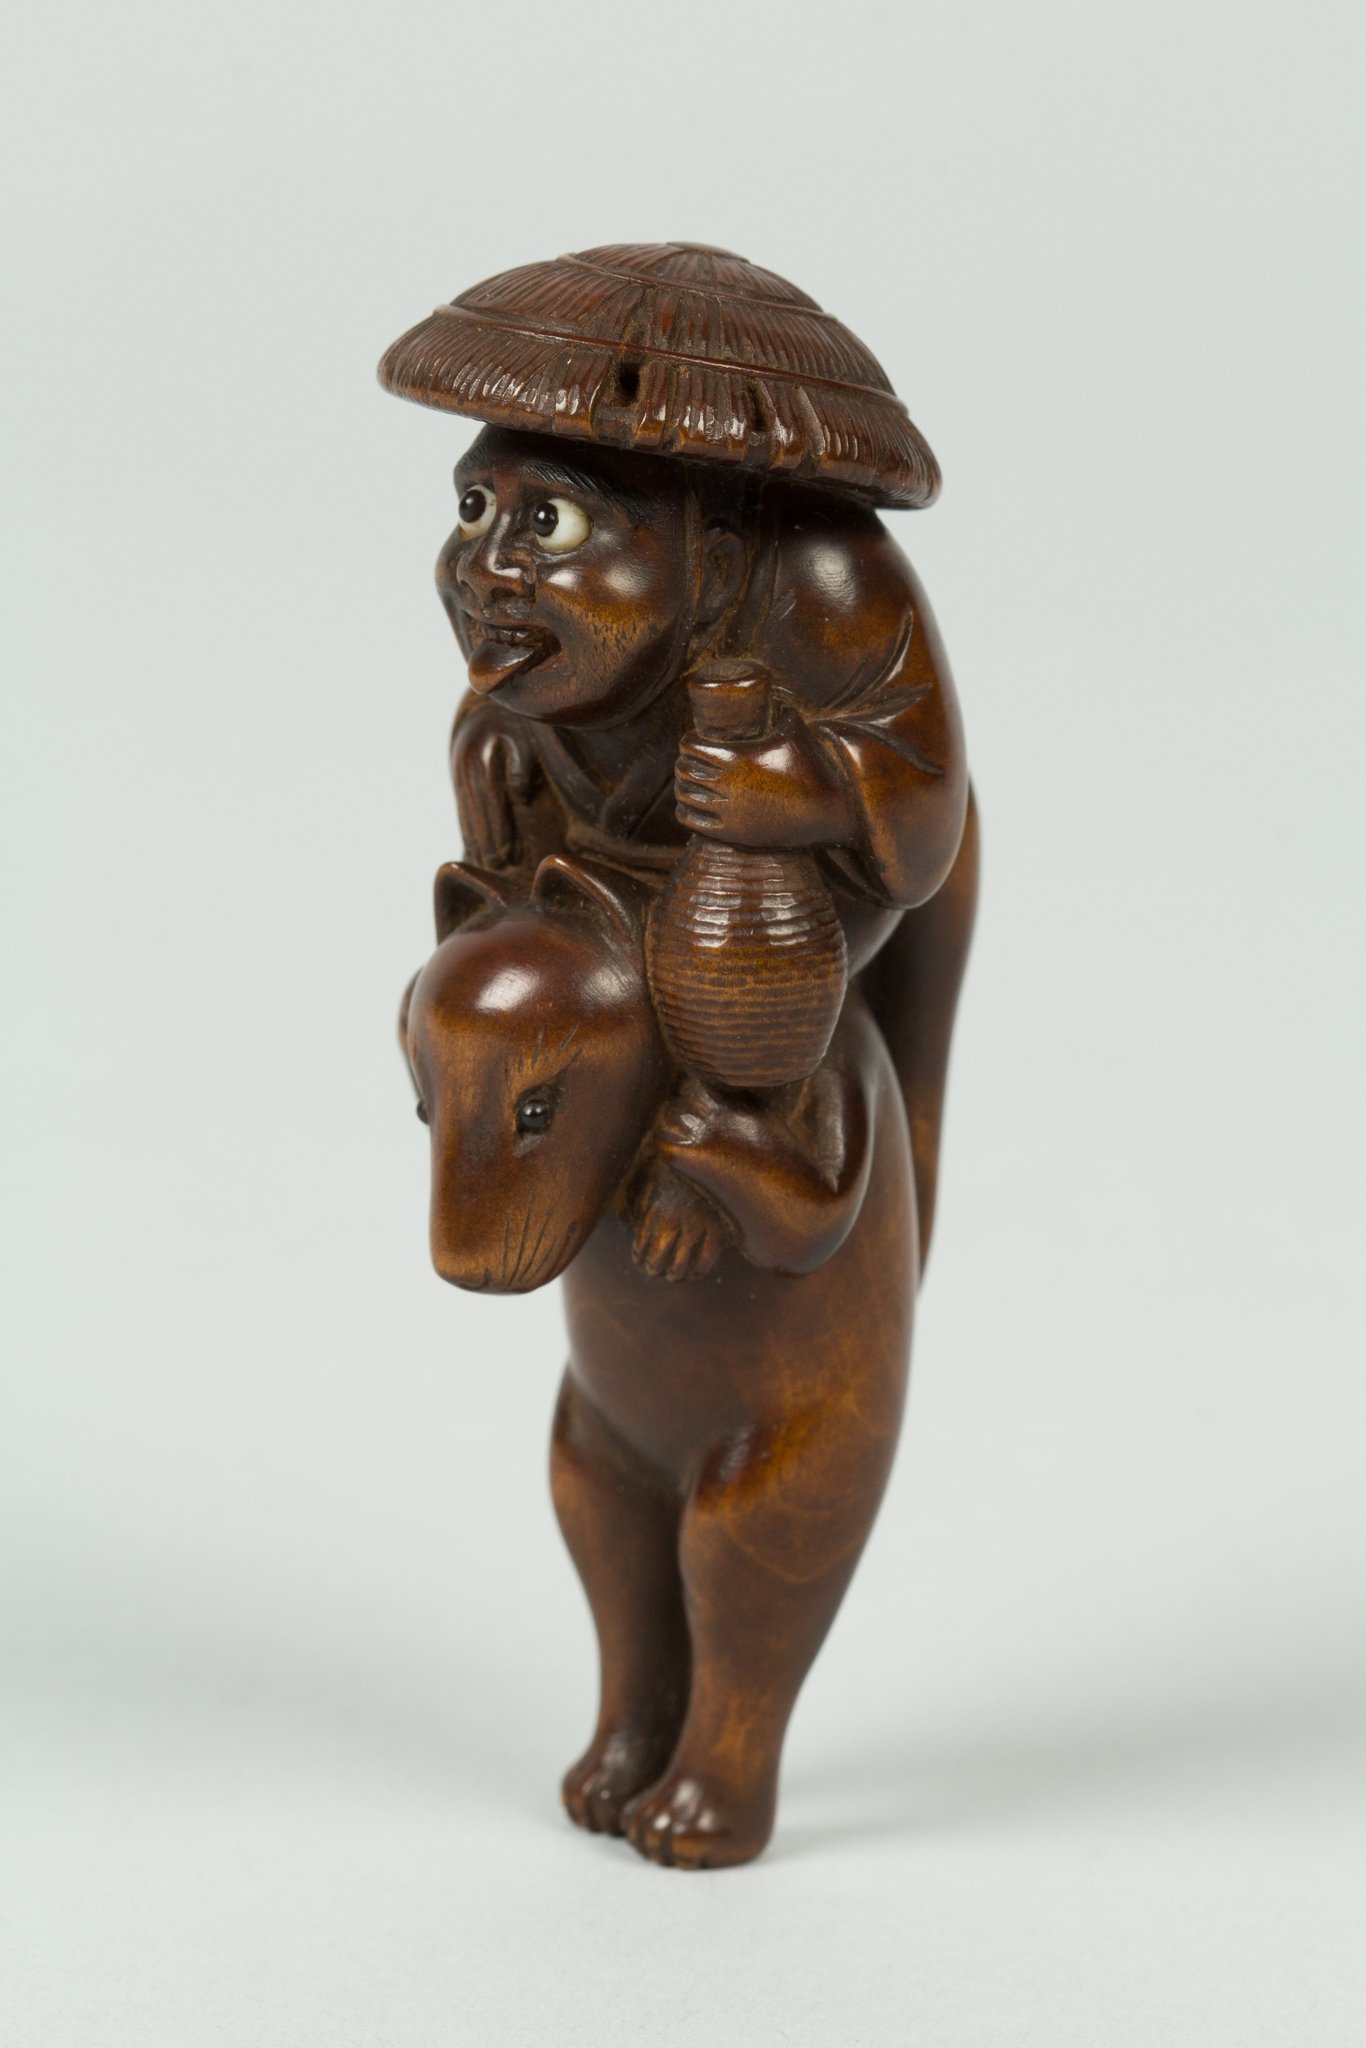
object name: netsuke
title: Netsuke of Boy Sitting on the Shoulders of an Animal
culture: japanese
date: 1701-1800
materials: wood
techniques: inlay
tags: animals,boys